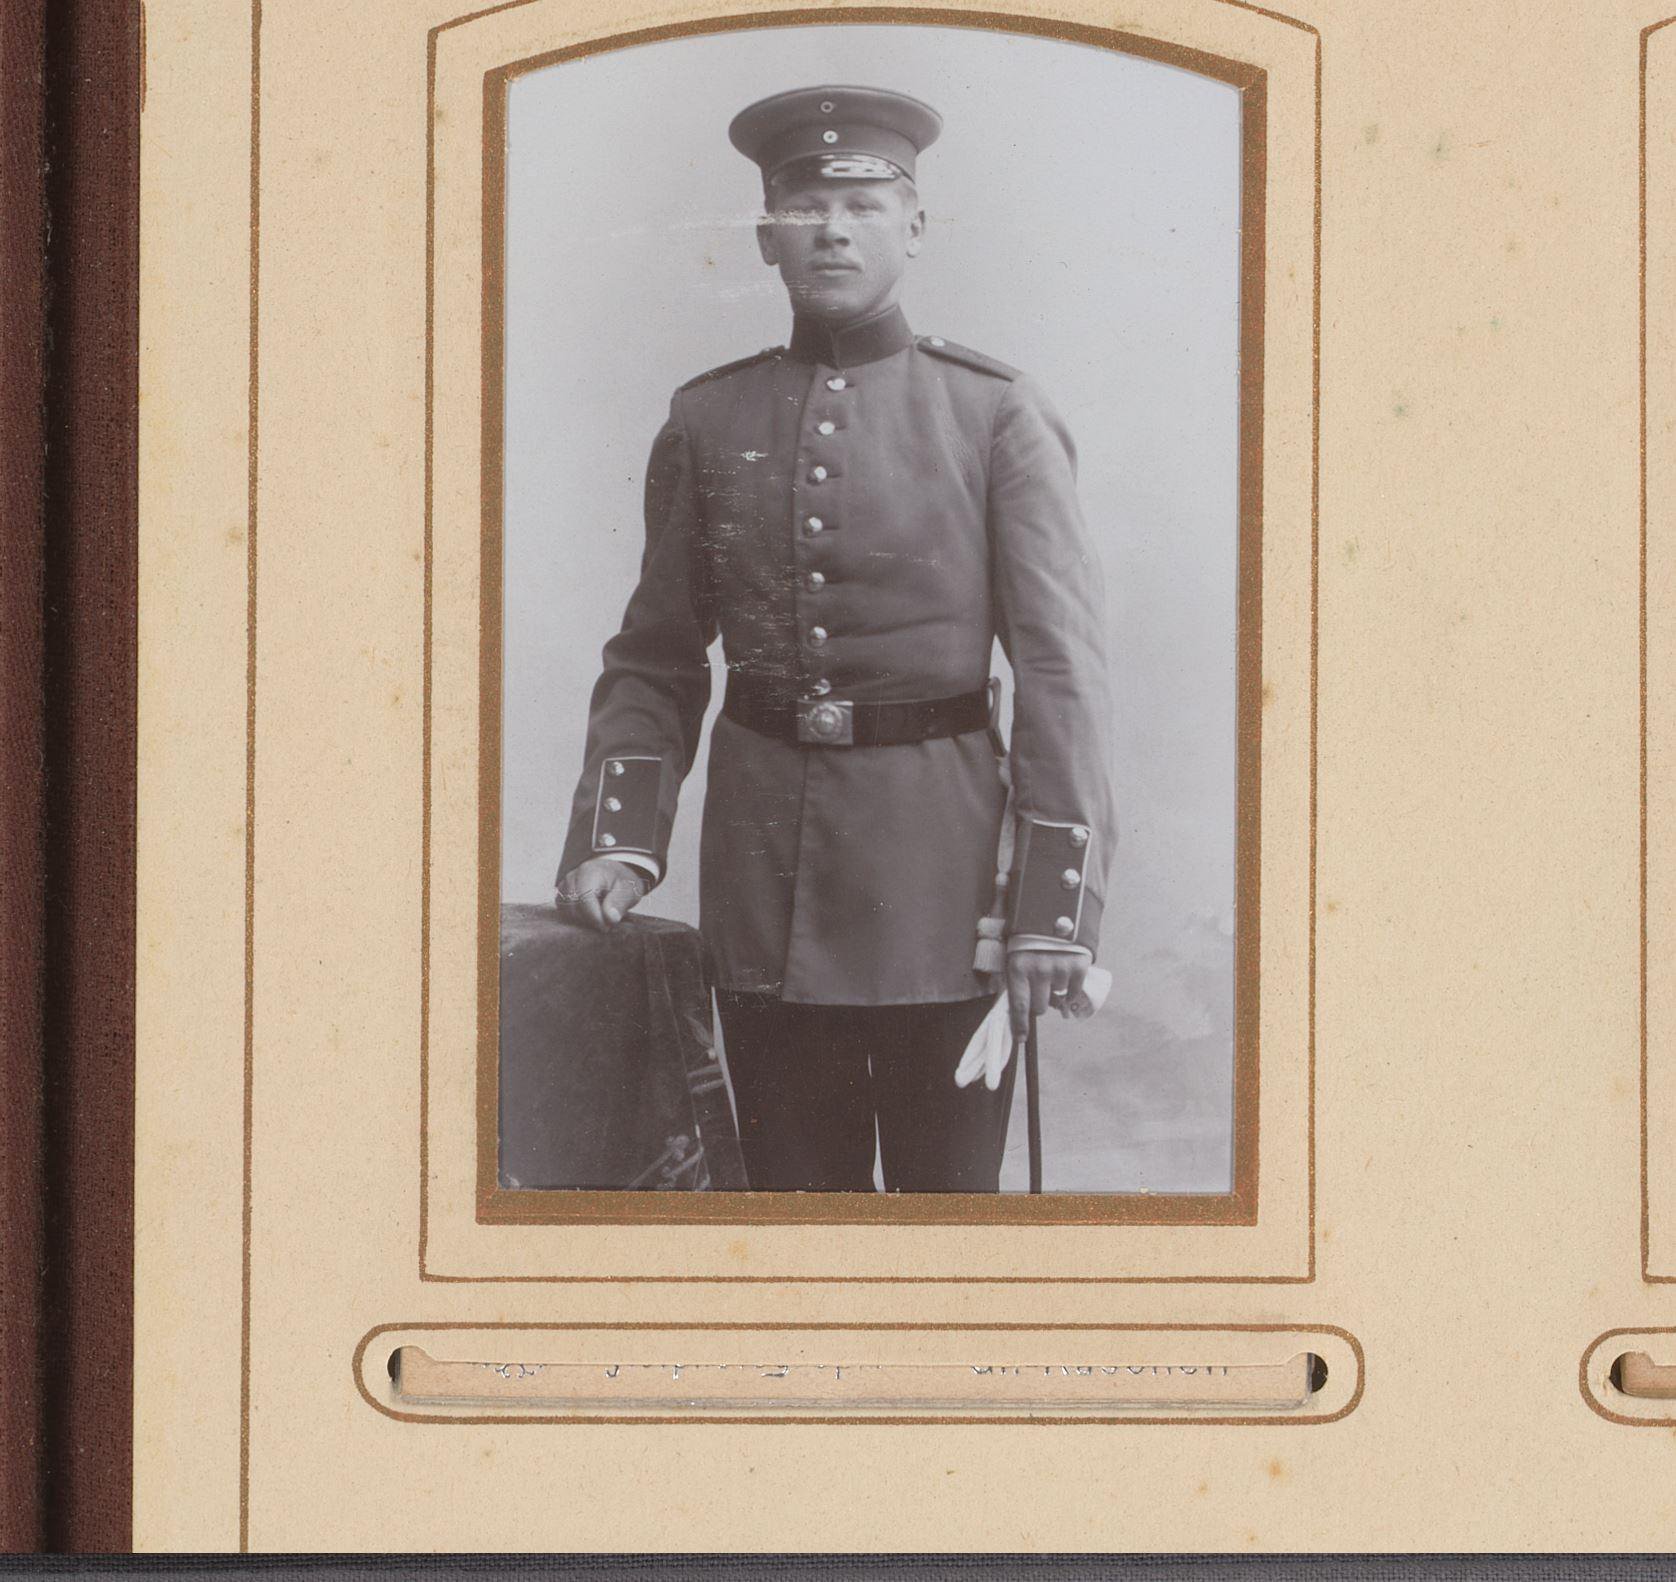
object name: photograph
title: Portret van een jongeman in uniform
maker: richard klau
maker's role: fotograaf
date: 1880-1910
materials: cardboard, photographic support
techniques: collodion silver print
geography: cottbus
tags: historical persons, (military) uniforms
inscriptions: inscription: ‘R. Klau/ Hofphotograph/ Cottbus/ Gr.-Räschen’